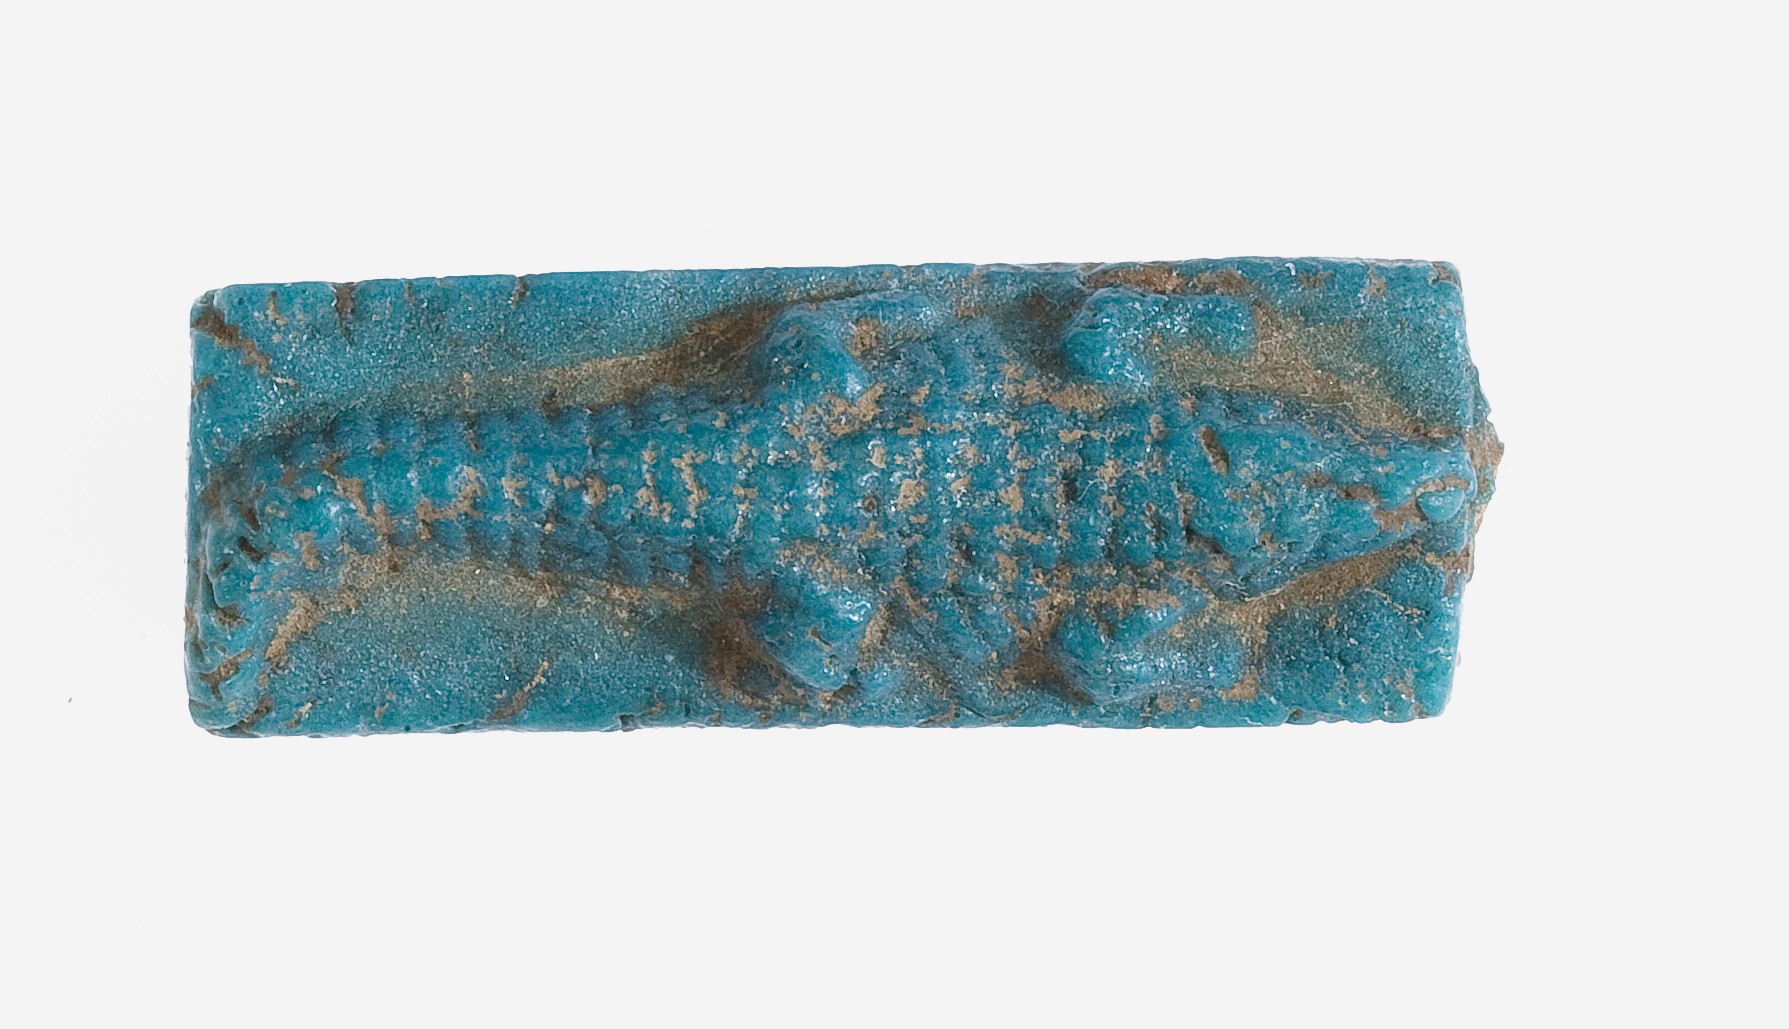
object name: amulet, crocodile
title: Crocodile Amulet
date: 1390-1352 BCE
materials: faience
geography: egypt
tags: crocodiles